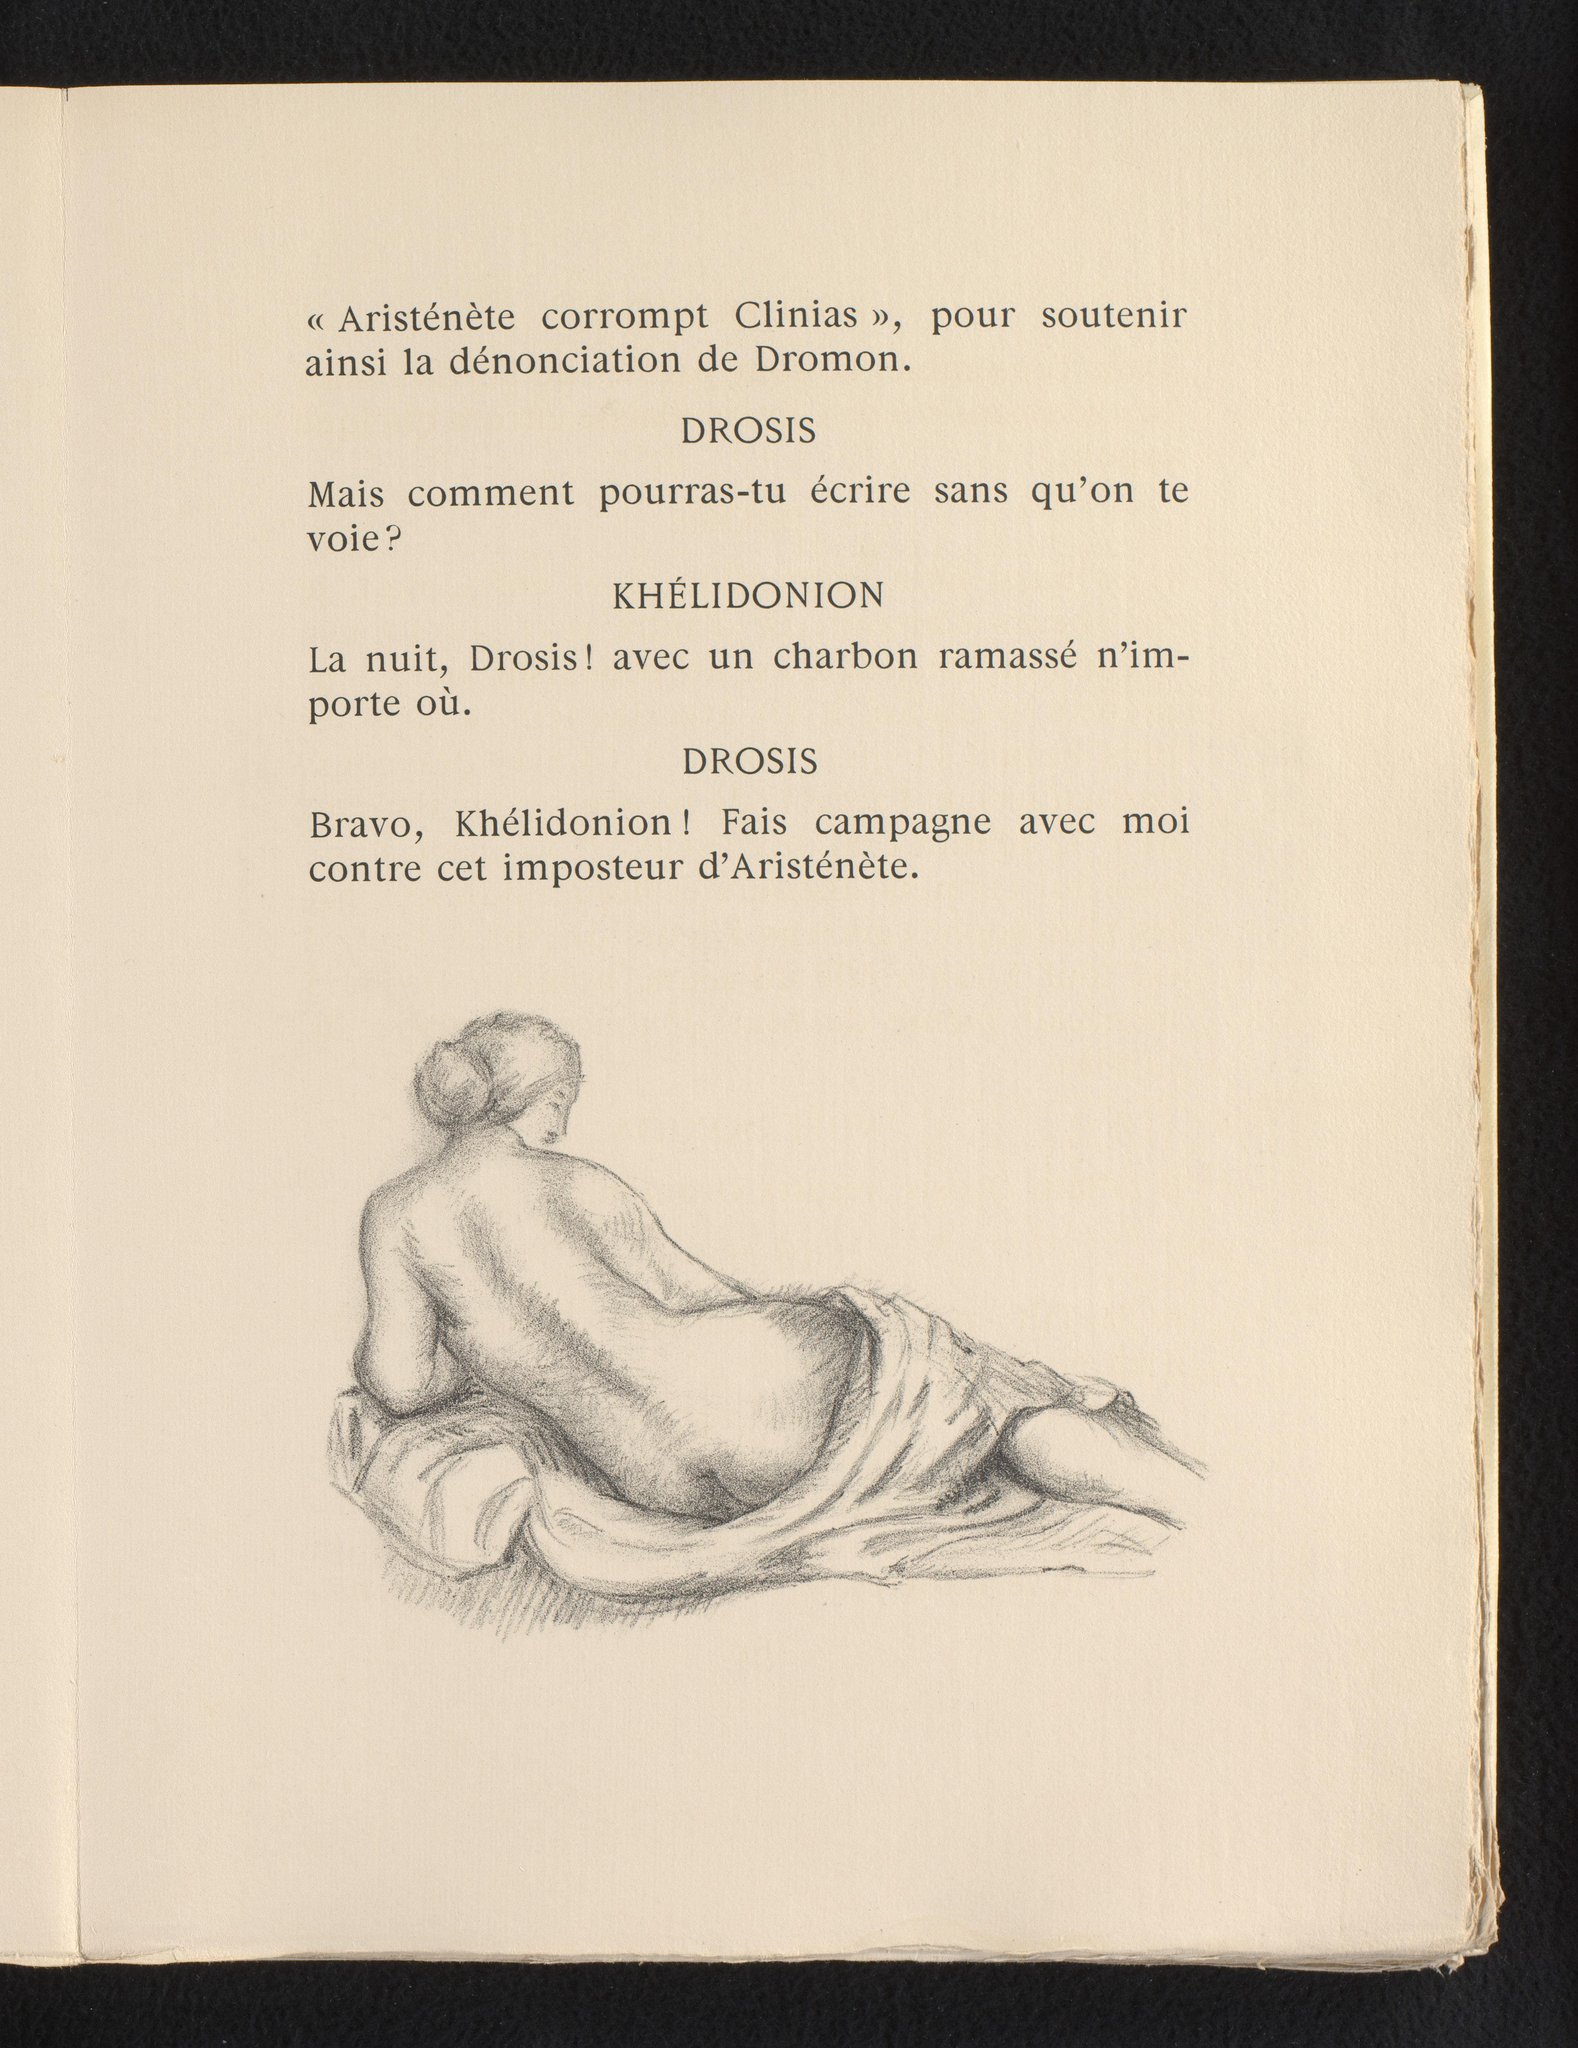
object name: print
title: Liggende naakte vrouw, op de rug gezien, leunend op een arm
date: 1948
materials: paper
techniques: letterpress printing, lithograph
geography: paris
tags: lying on one side, with uplifted upper part of the body and leaning on the arm - aa - female human figure, woman (showing herself) undressed, quasi-nude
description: Prent uit: Lucianus van Samosata. Dialogues des Courtisanes. [Vertaald uit het Grieks door] Charles Astruc. Parijs: s.n., 1948, p. 61.